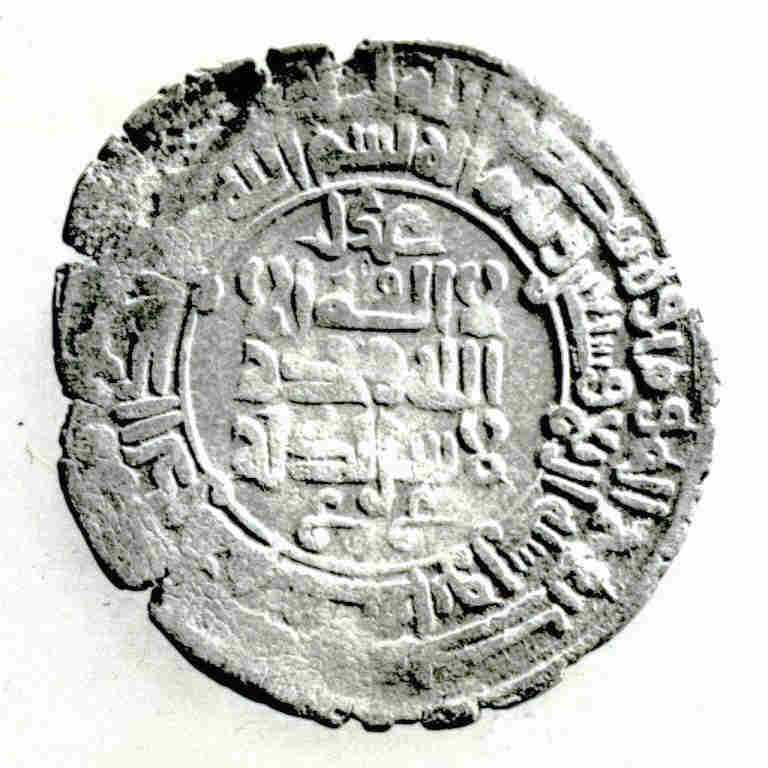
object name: coin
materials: silver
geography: nishapur